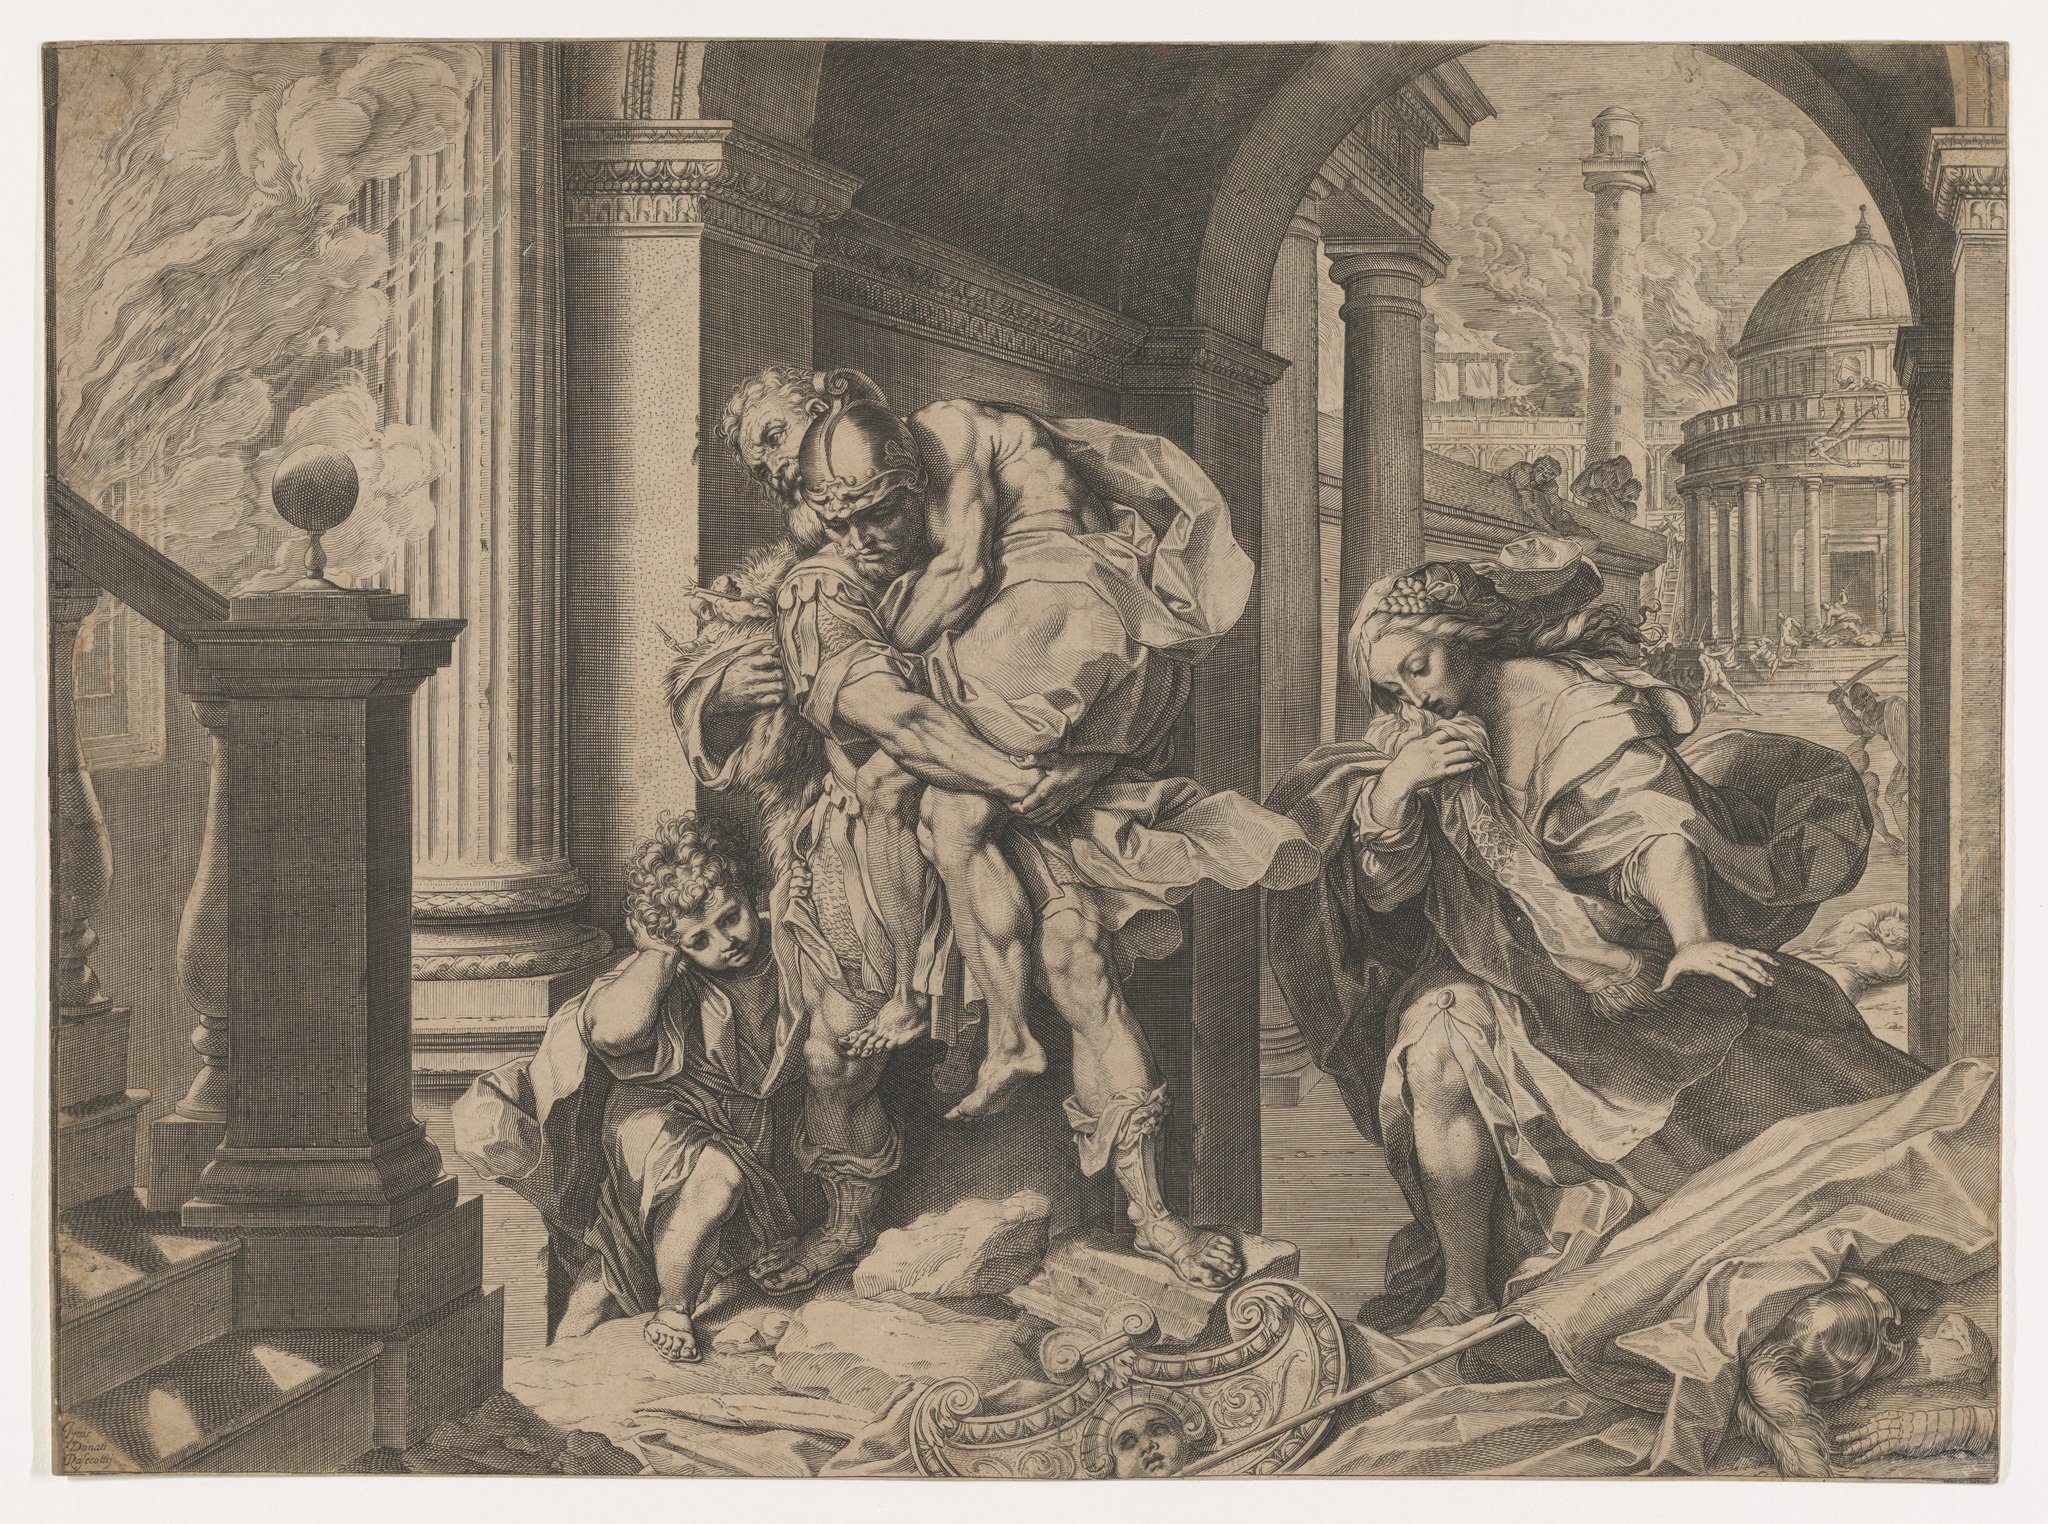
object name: print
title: Aeneas and his family fleeing Troy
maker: agostino carracci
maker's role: artist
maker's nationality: italian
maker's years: 1557-1602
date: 1595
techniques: engraving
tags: trojan war,children,men,women,aeneas